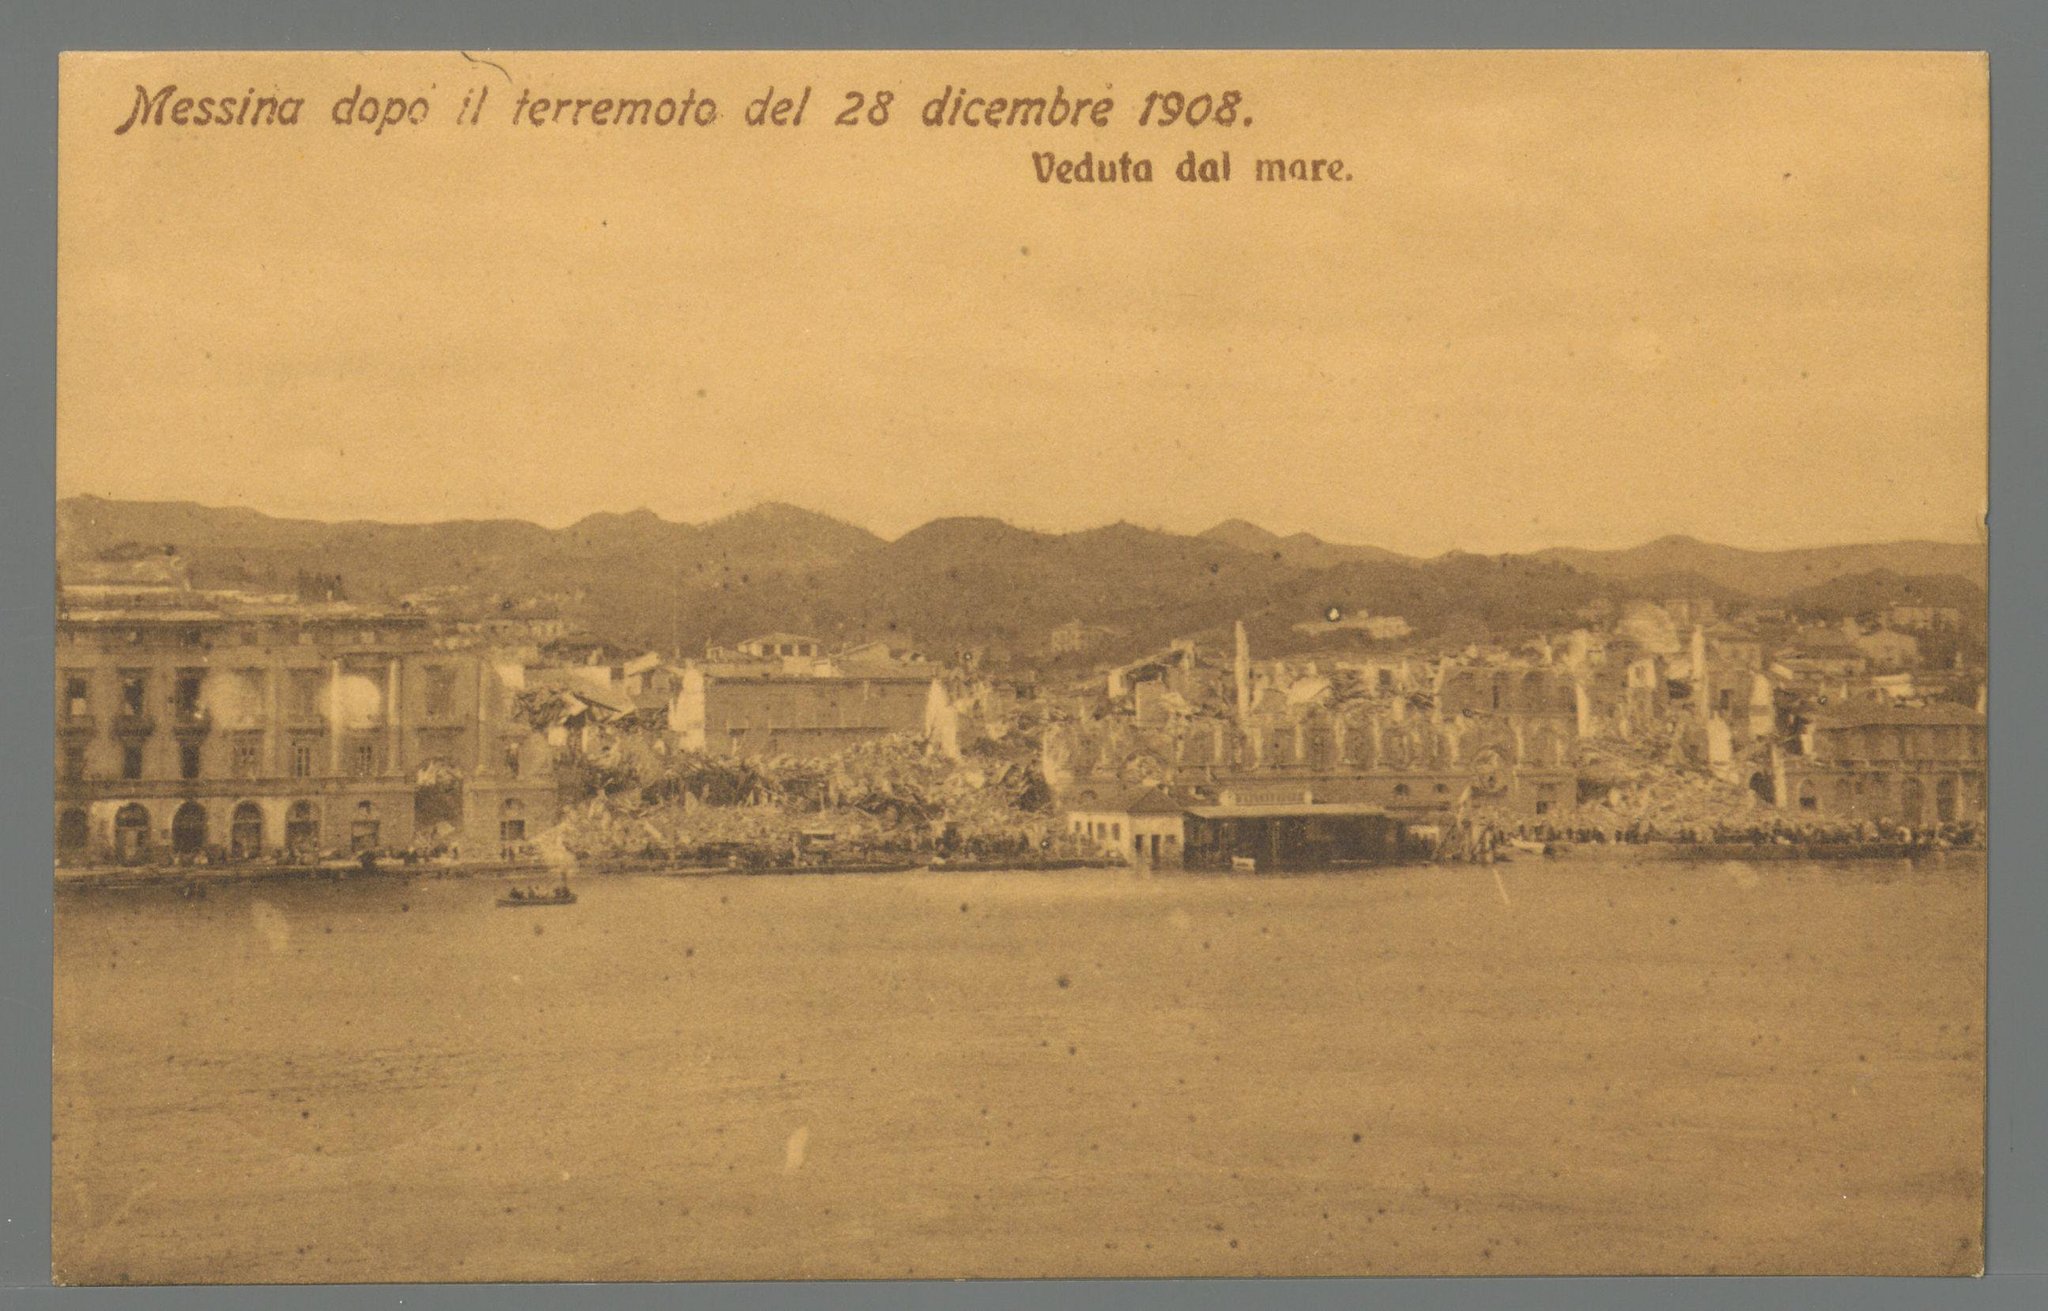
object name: photomechanical print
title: Messina dopo il terremoto del 28 dicembre 1908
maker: Anonymous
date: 1908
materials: cardboard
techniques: photograph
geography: milan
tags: harbour, consequences of an earthquake, city-view, and landscape with man-made constructions (+ city(-scape) with figures, staffage)